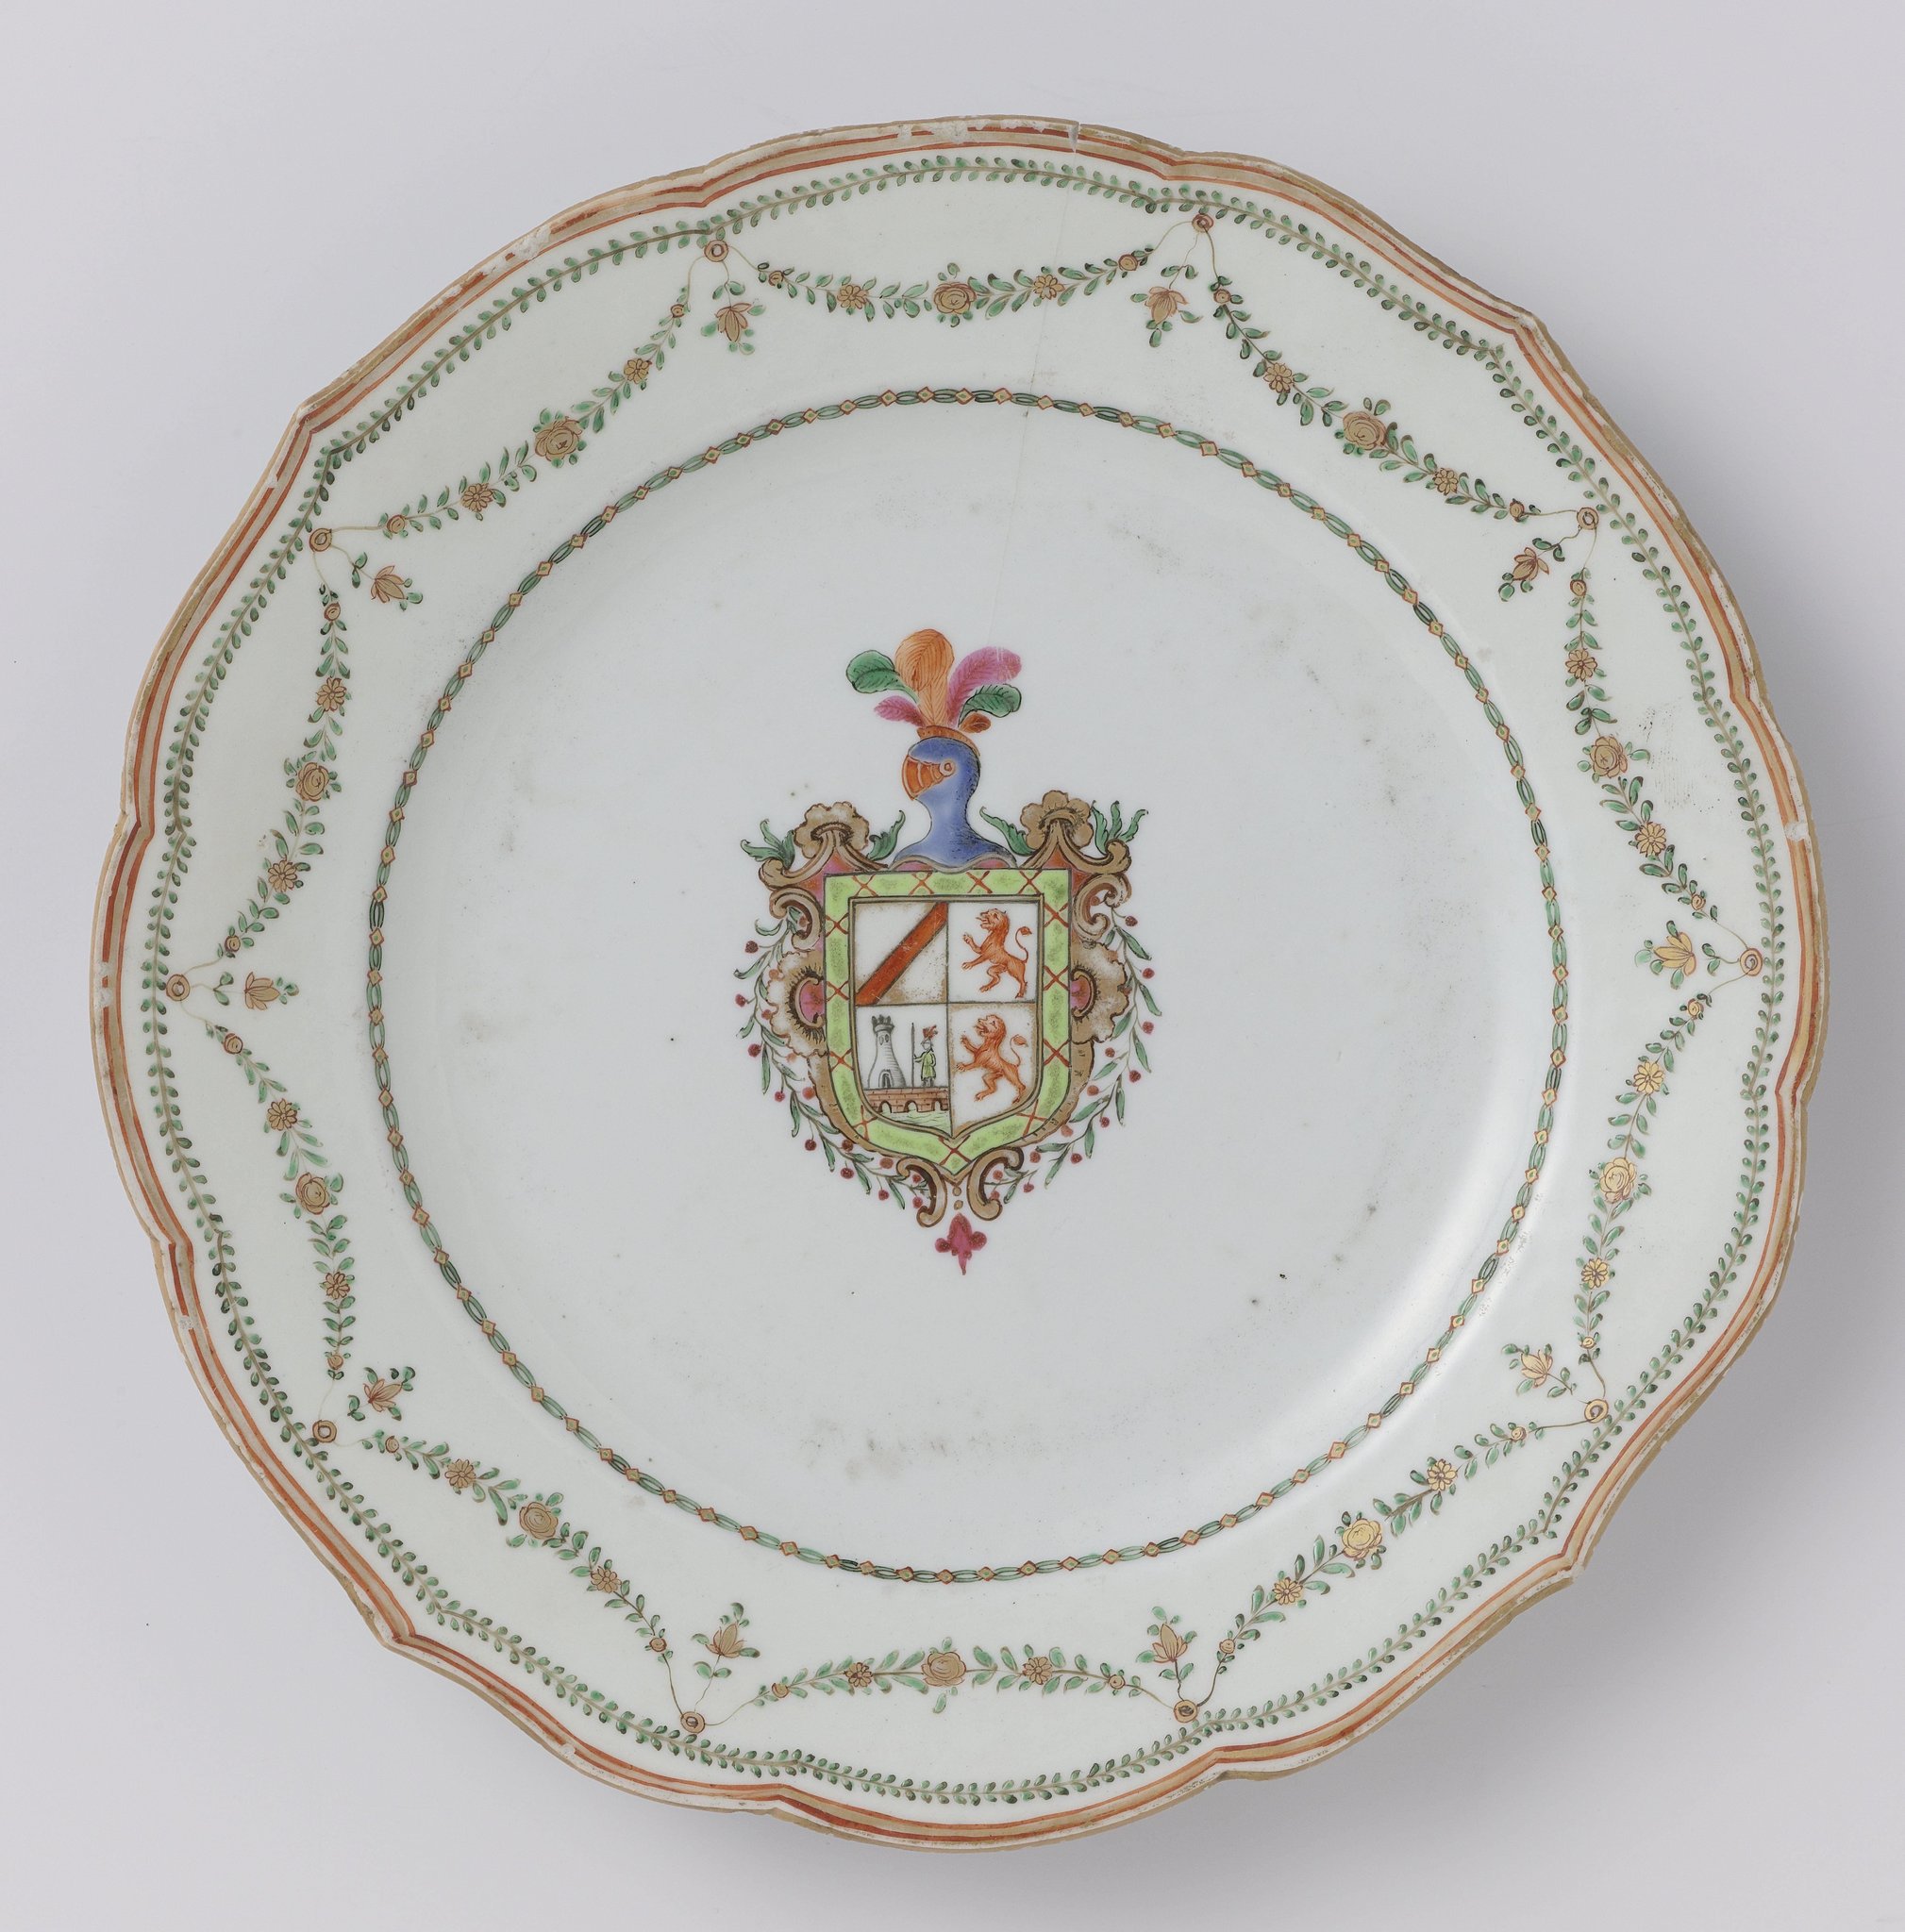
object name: plate dish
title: Plate with a coat of arms and garlands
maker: Anonymous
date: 1740-1760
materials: glaze, gold, paint, porcelain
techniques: firing, gilding, turning, vitrification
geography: china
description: Bord met een gekartelde rand, beschilderd in emails en goud met in het cemtrum een familiewapen, omgeven door guirlandes en ornamentbanden op de wand en rand.